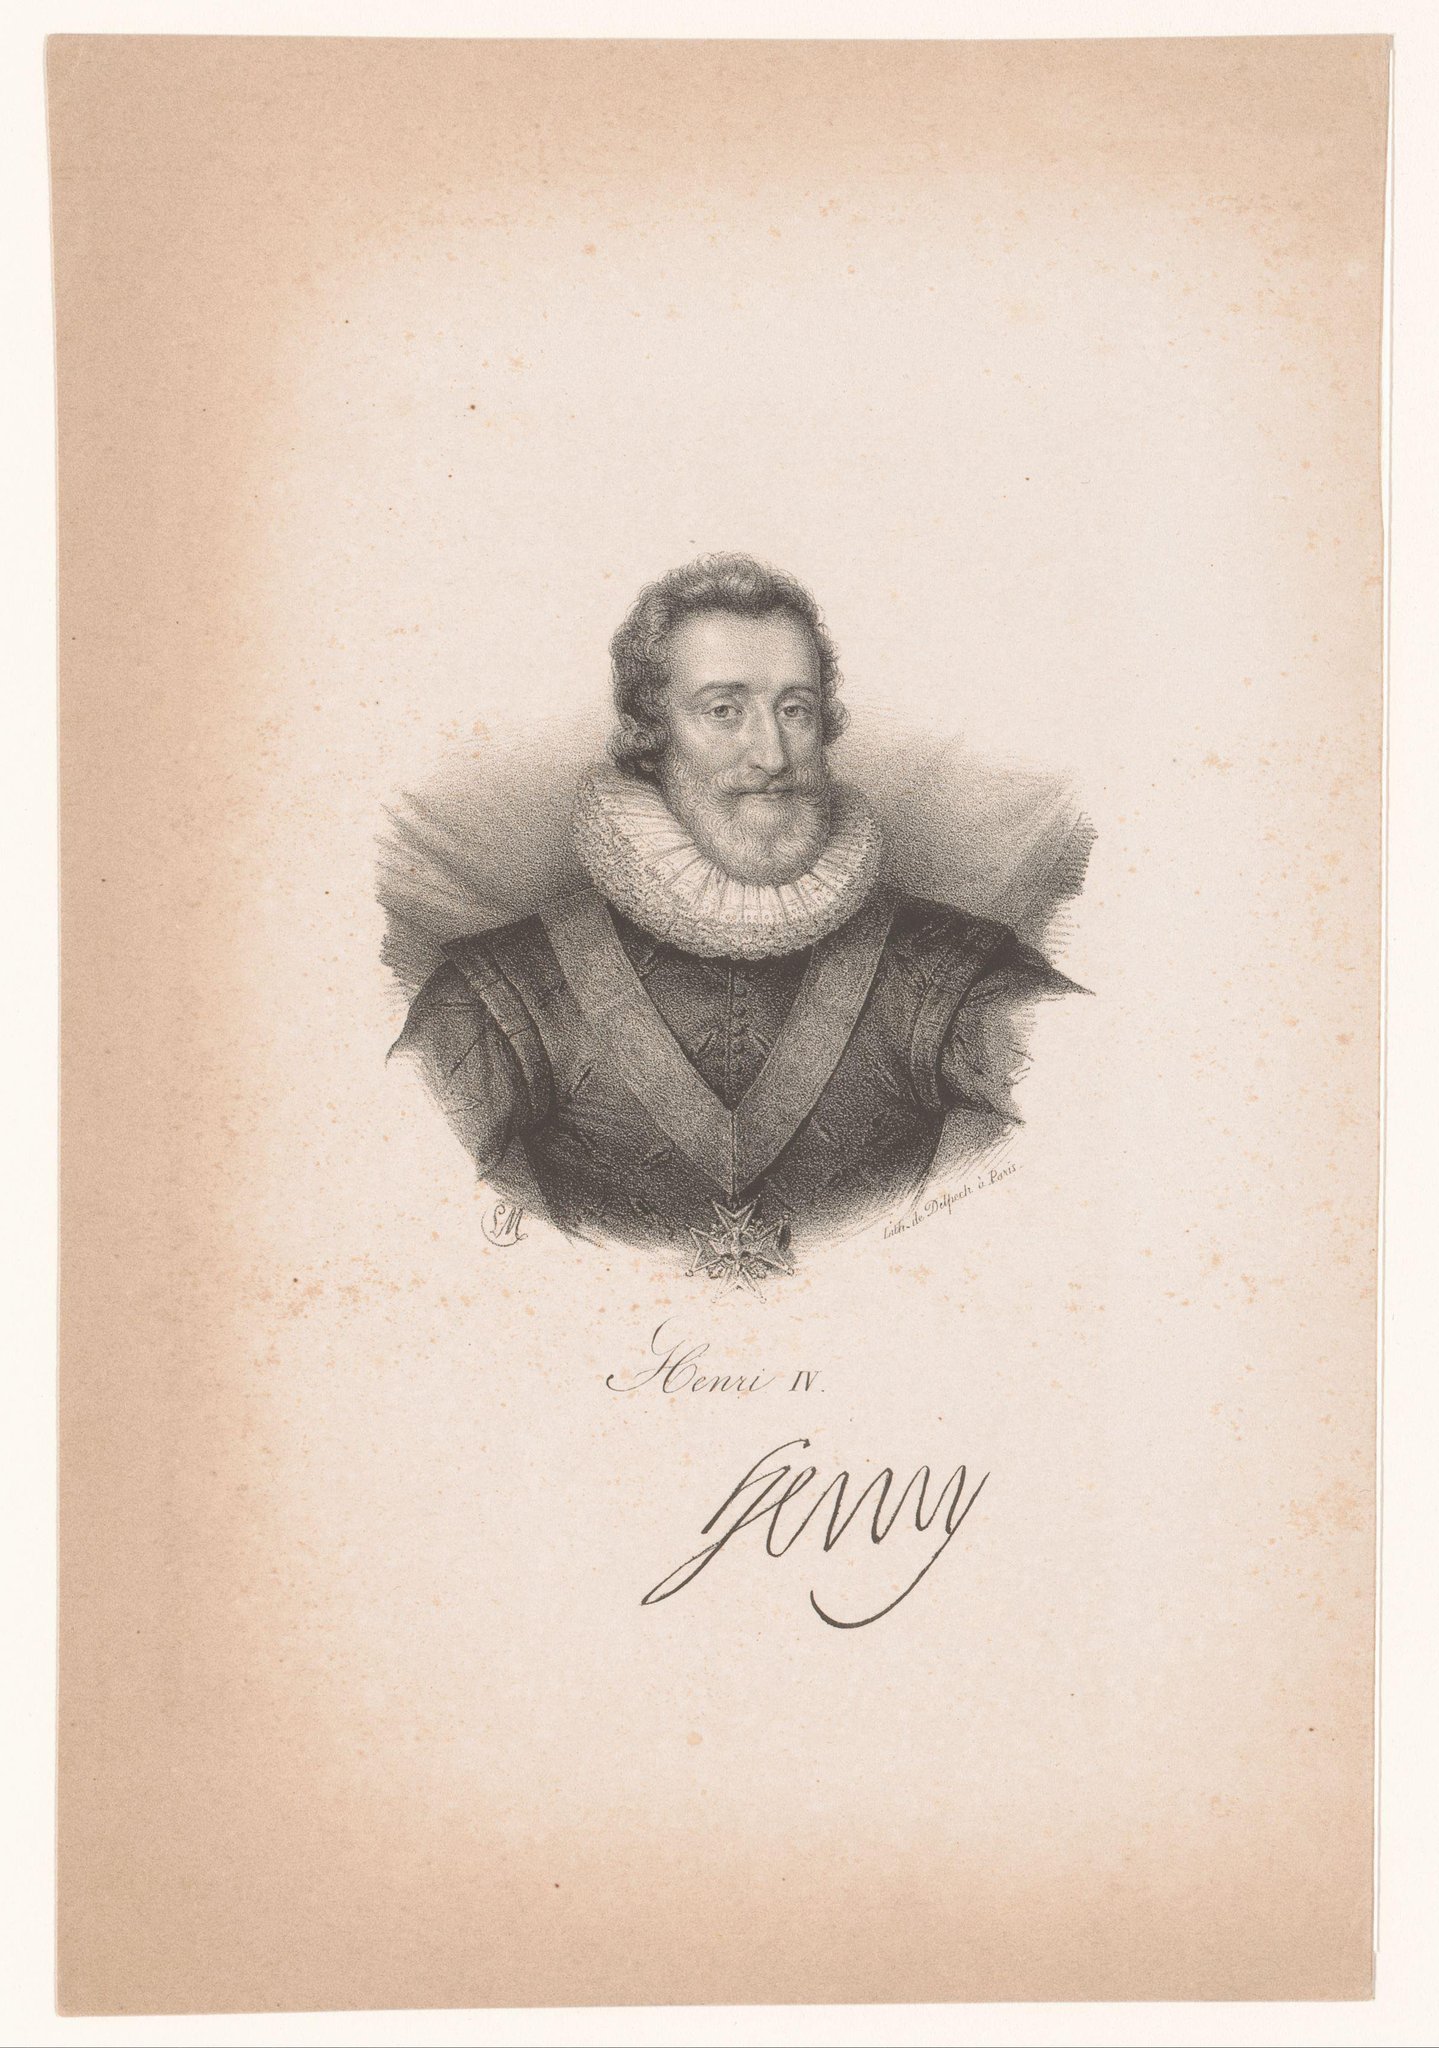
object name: print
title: Portret van Hendrik IV, koning van Frankrijk en Navarra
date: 1825-1842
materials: paper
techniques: lithograph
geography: paris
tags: paris, hendrik iv (koning van frankrijk en navarra), historical persons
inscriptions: collector's mark: Lugt 2228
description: Prent waarschijnlijk gebruikt voor: Rois et reines de France: depuis l'origine de la monarchie jusqu'à nos jours. 3 dln. Parijs: veuve Delpech, 1833-1840. En/of voor: Iconographie française ou recueil des portraits des personnages les plus illustres qui ont paru en France depuis François premier jusqu'à la fin du règne de Louis XVI (…). Parijs: veuve Delpech, 1828. En/of voor: Iconographie française ou choix de deux cents portraits d'hommes et de femmes qui se sont acquis en France, depuis le règne de Charles VII jusqu'à la fin de celui de Louis XVI (…). Parijs: veuve Delpech, 1840. Mogelijk komt de prent ook voor in eerdere en/of latere publicaties uitgegeven door veuve Delpech of haar opvolger Rosselin.